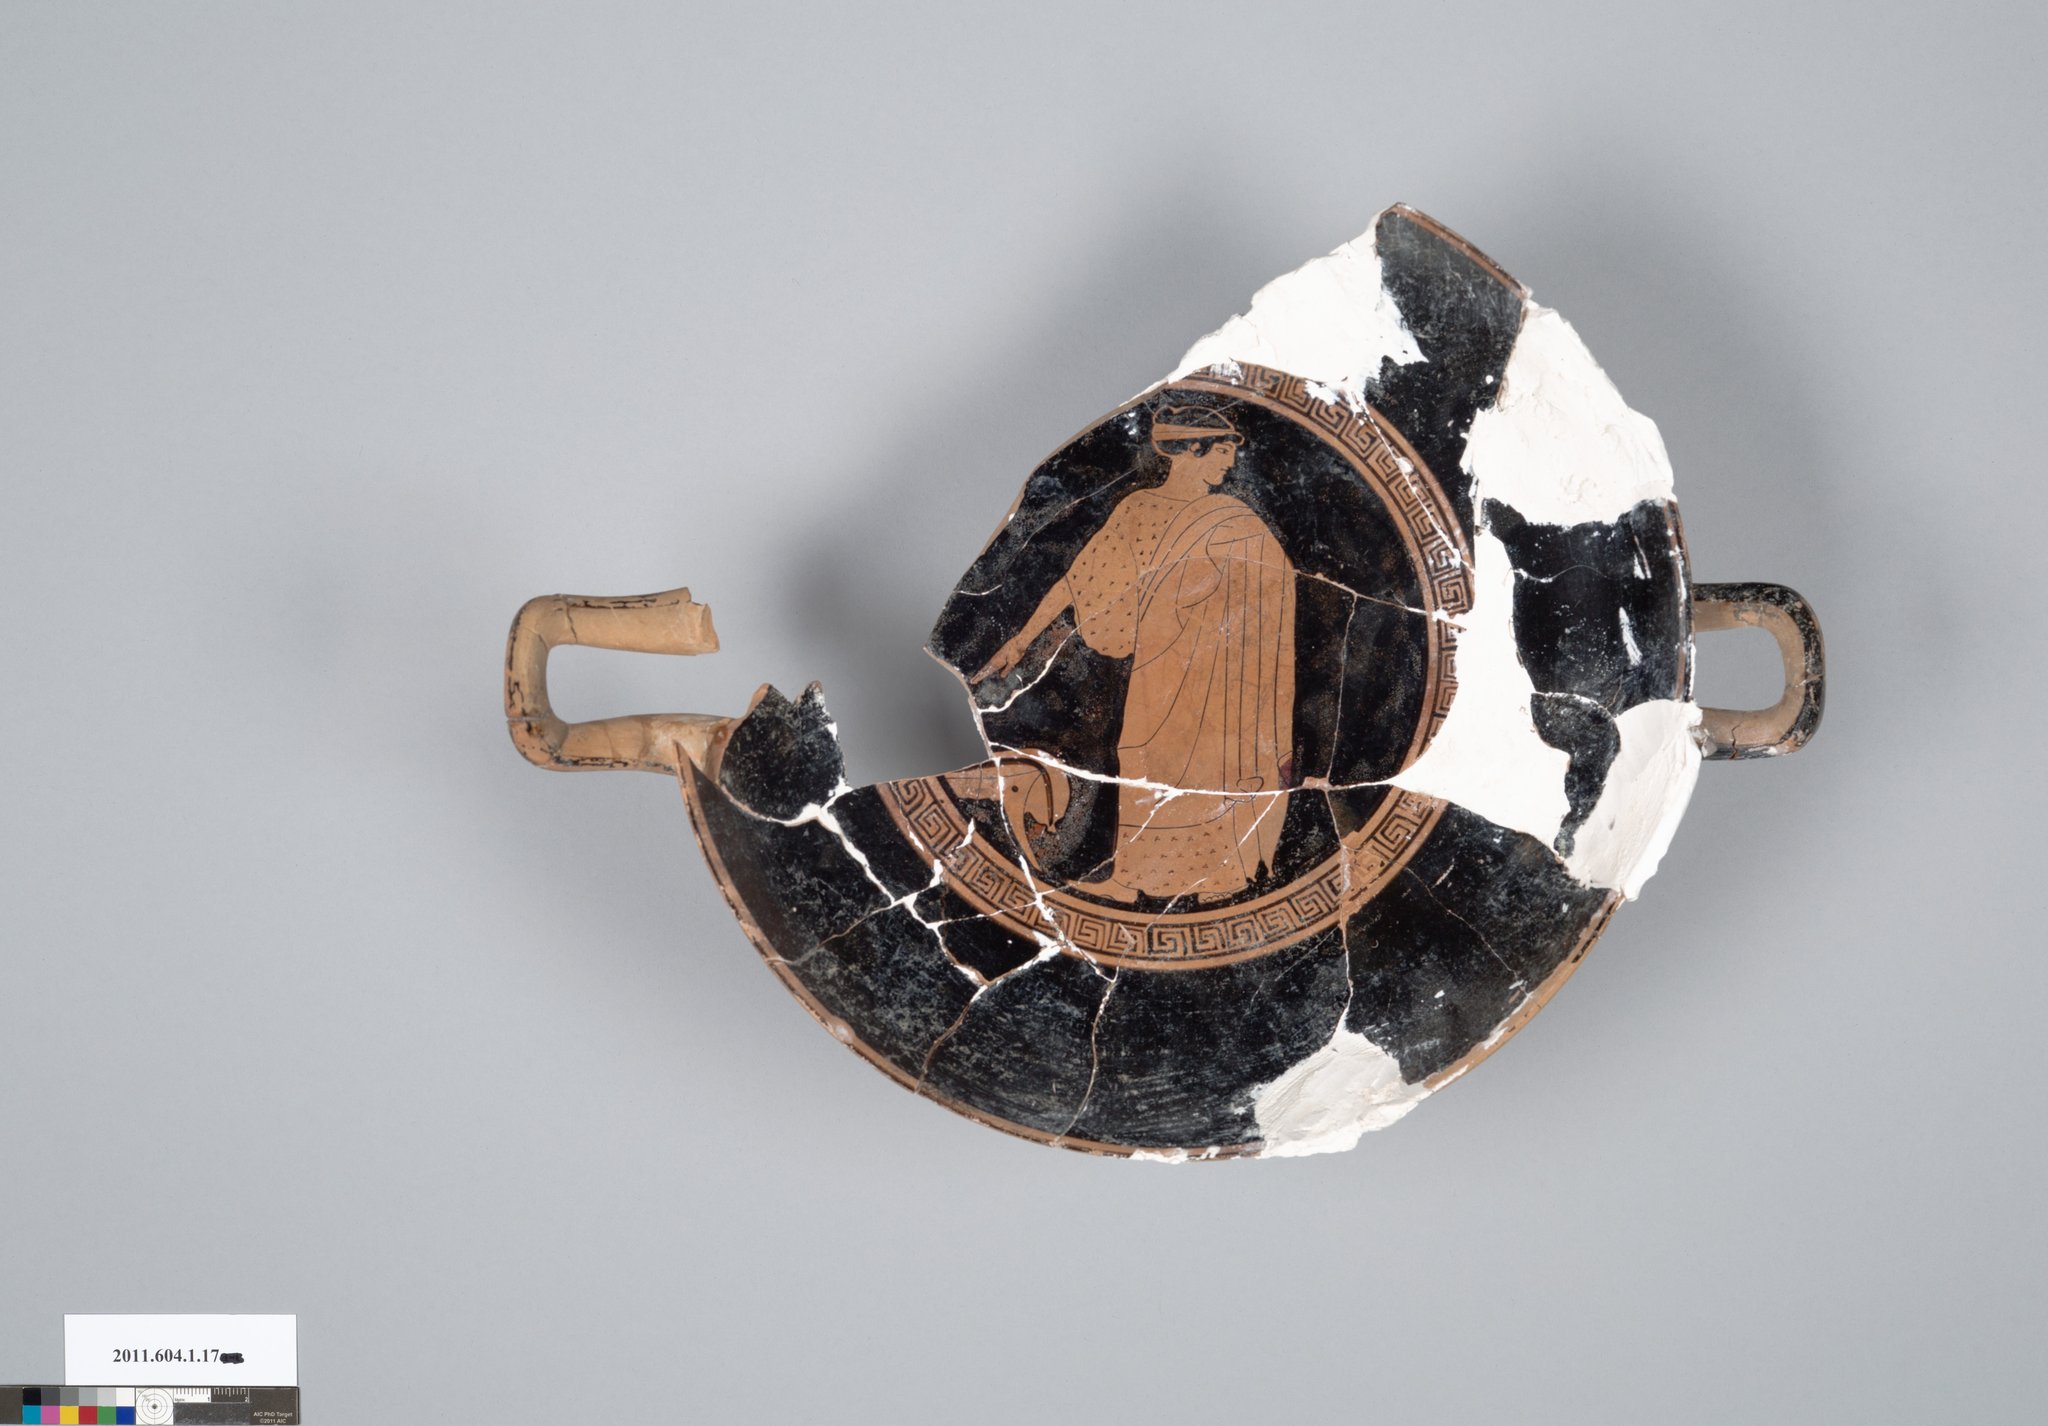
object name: kylix fragment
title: Terracotta fragments of a kylix (drinking cup)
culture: greek, attic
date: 470 BCE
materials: terracotta